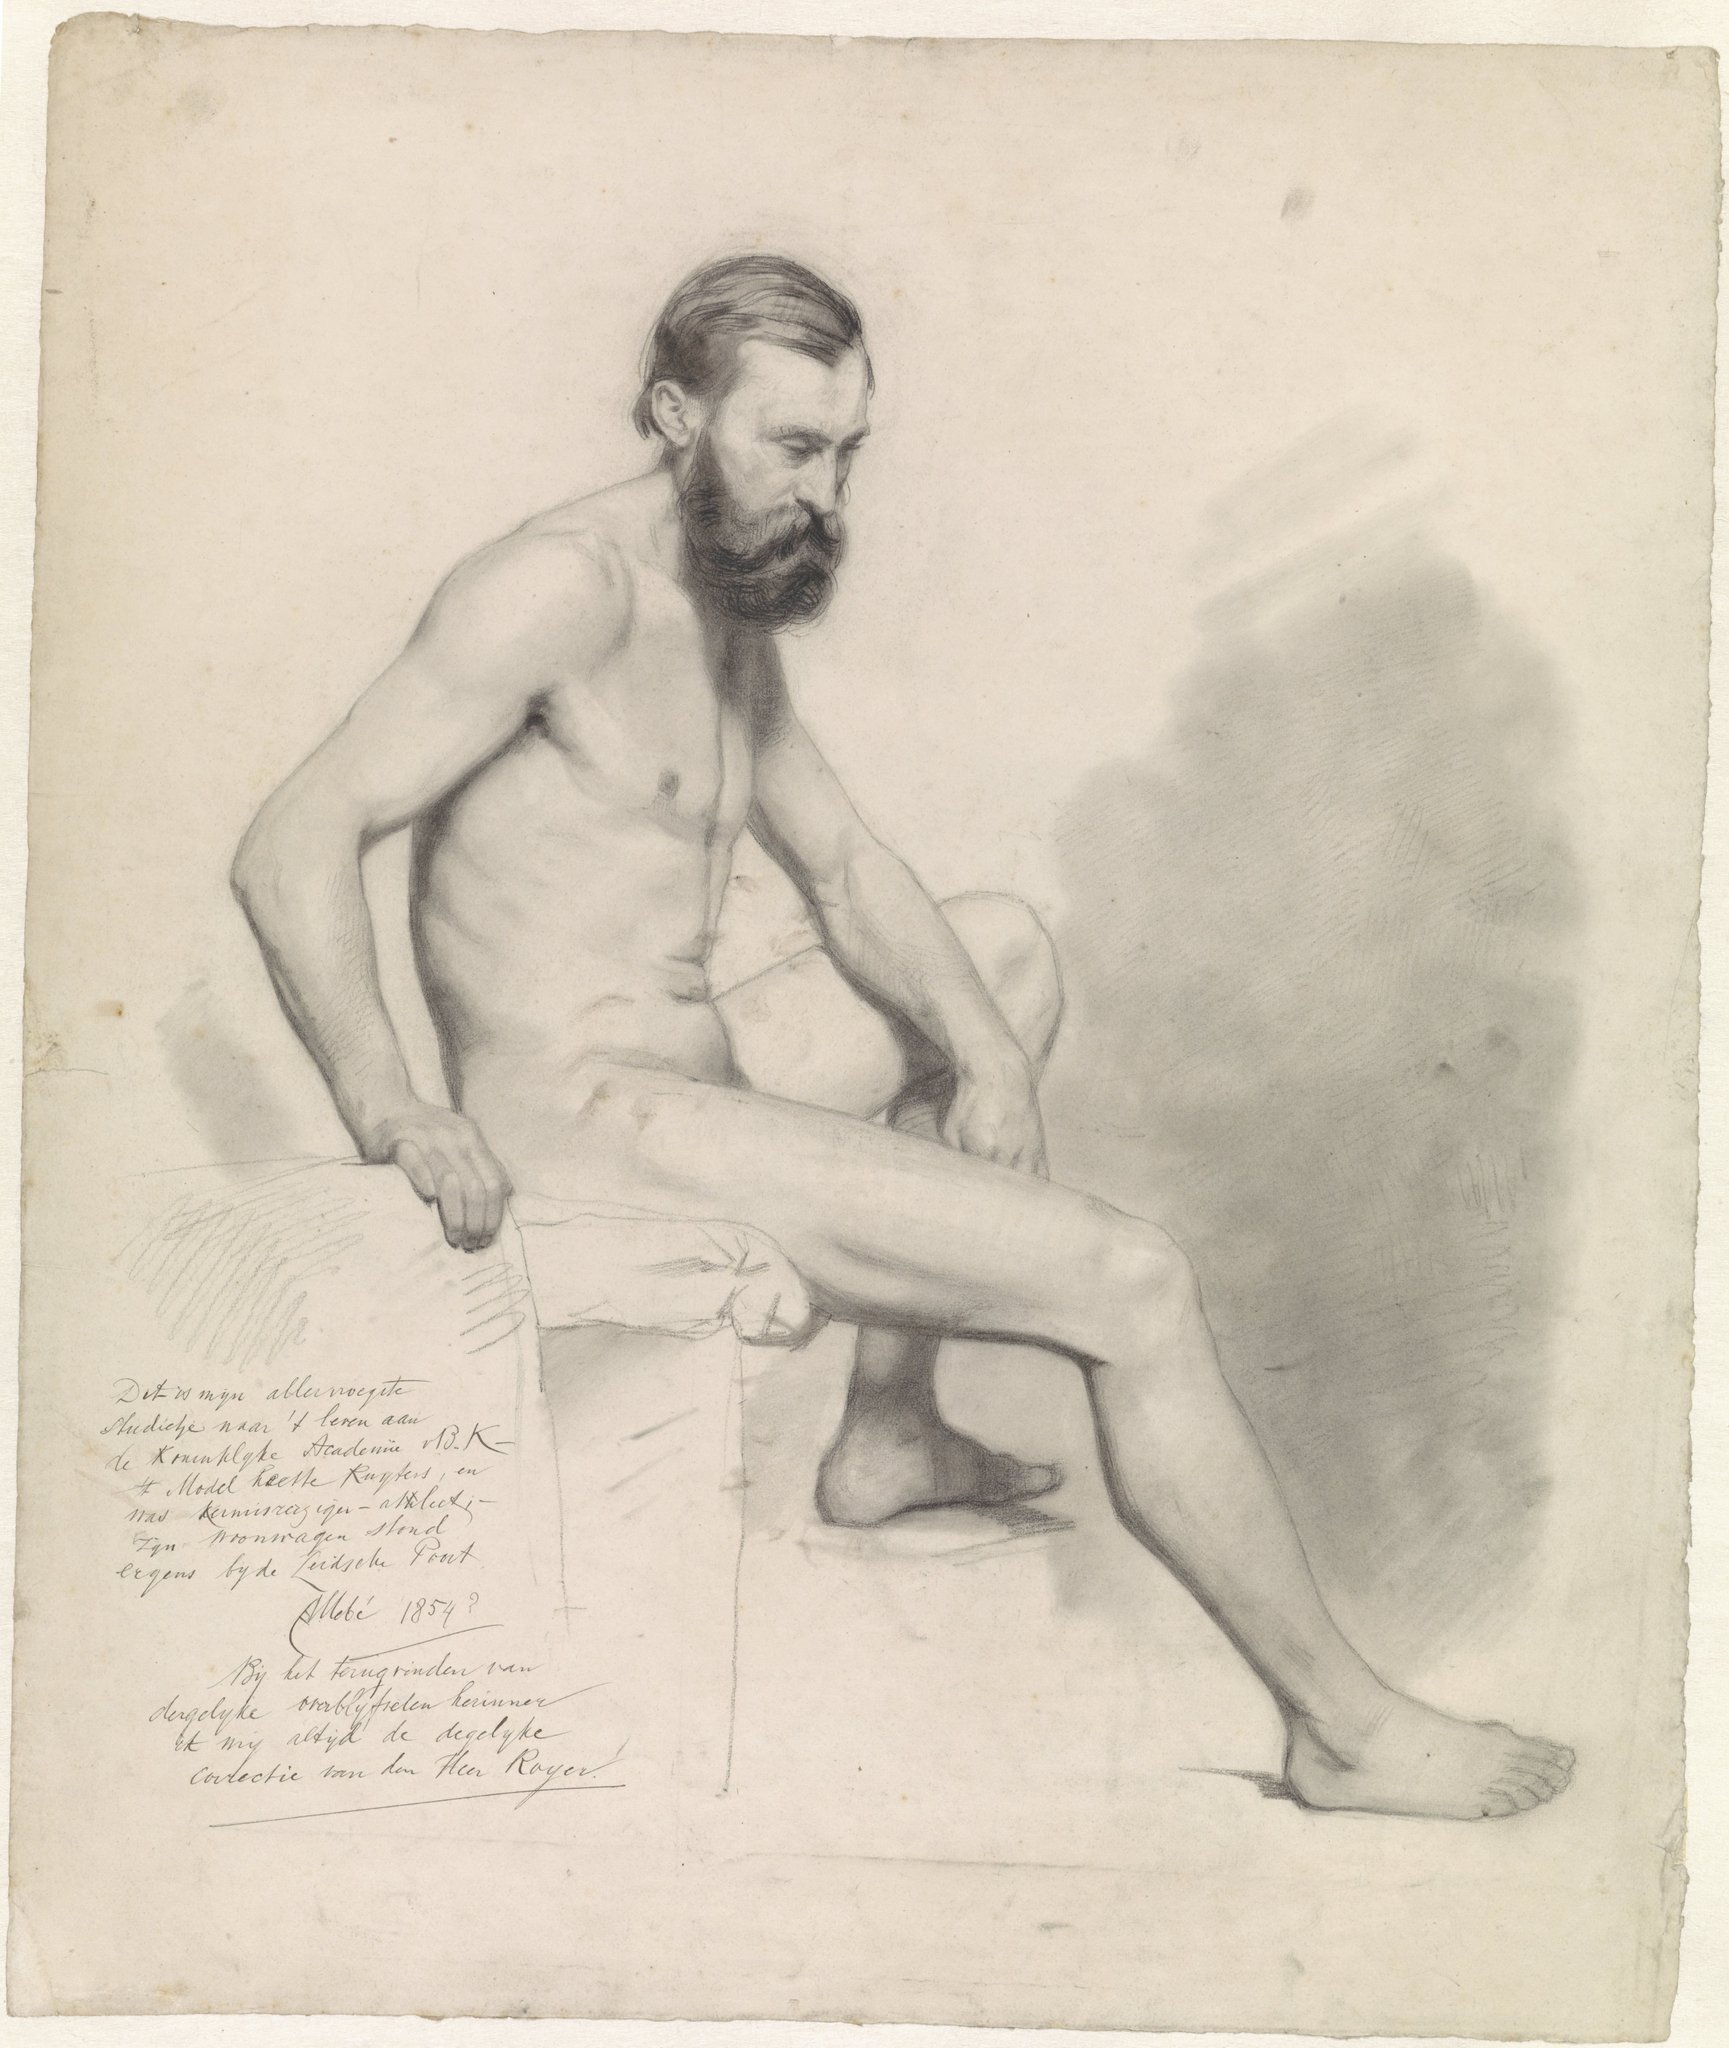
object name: drawing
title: Studie van een zittend mannelijk naakt, naar rechts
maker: august allebé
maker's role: draughtsman, print maker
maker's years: 1838-1927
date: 1854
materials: chalk, paper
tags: sitting figure